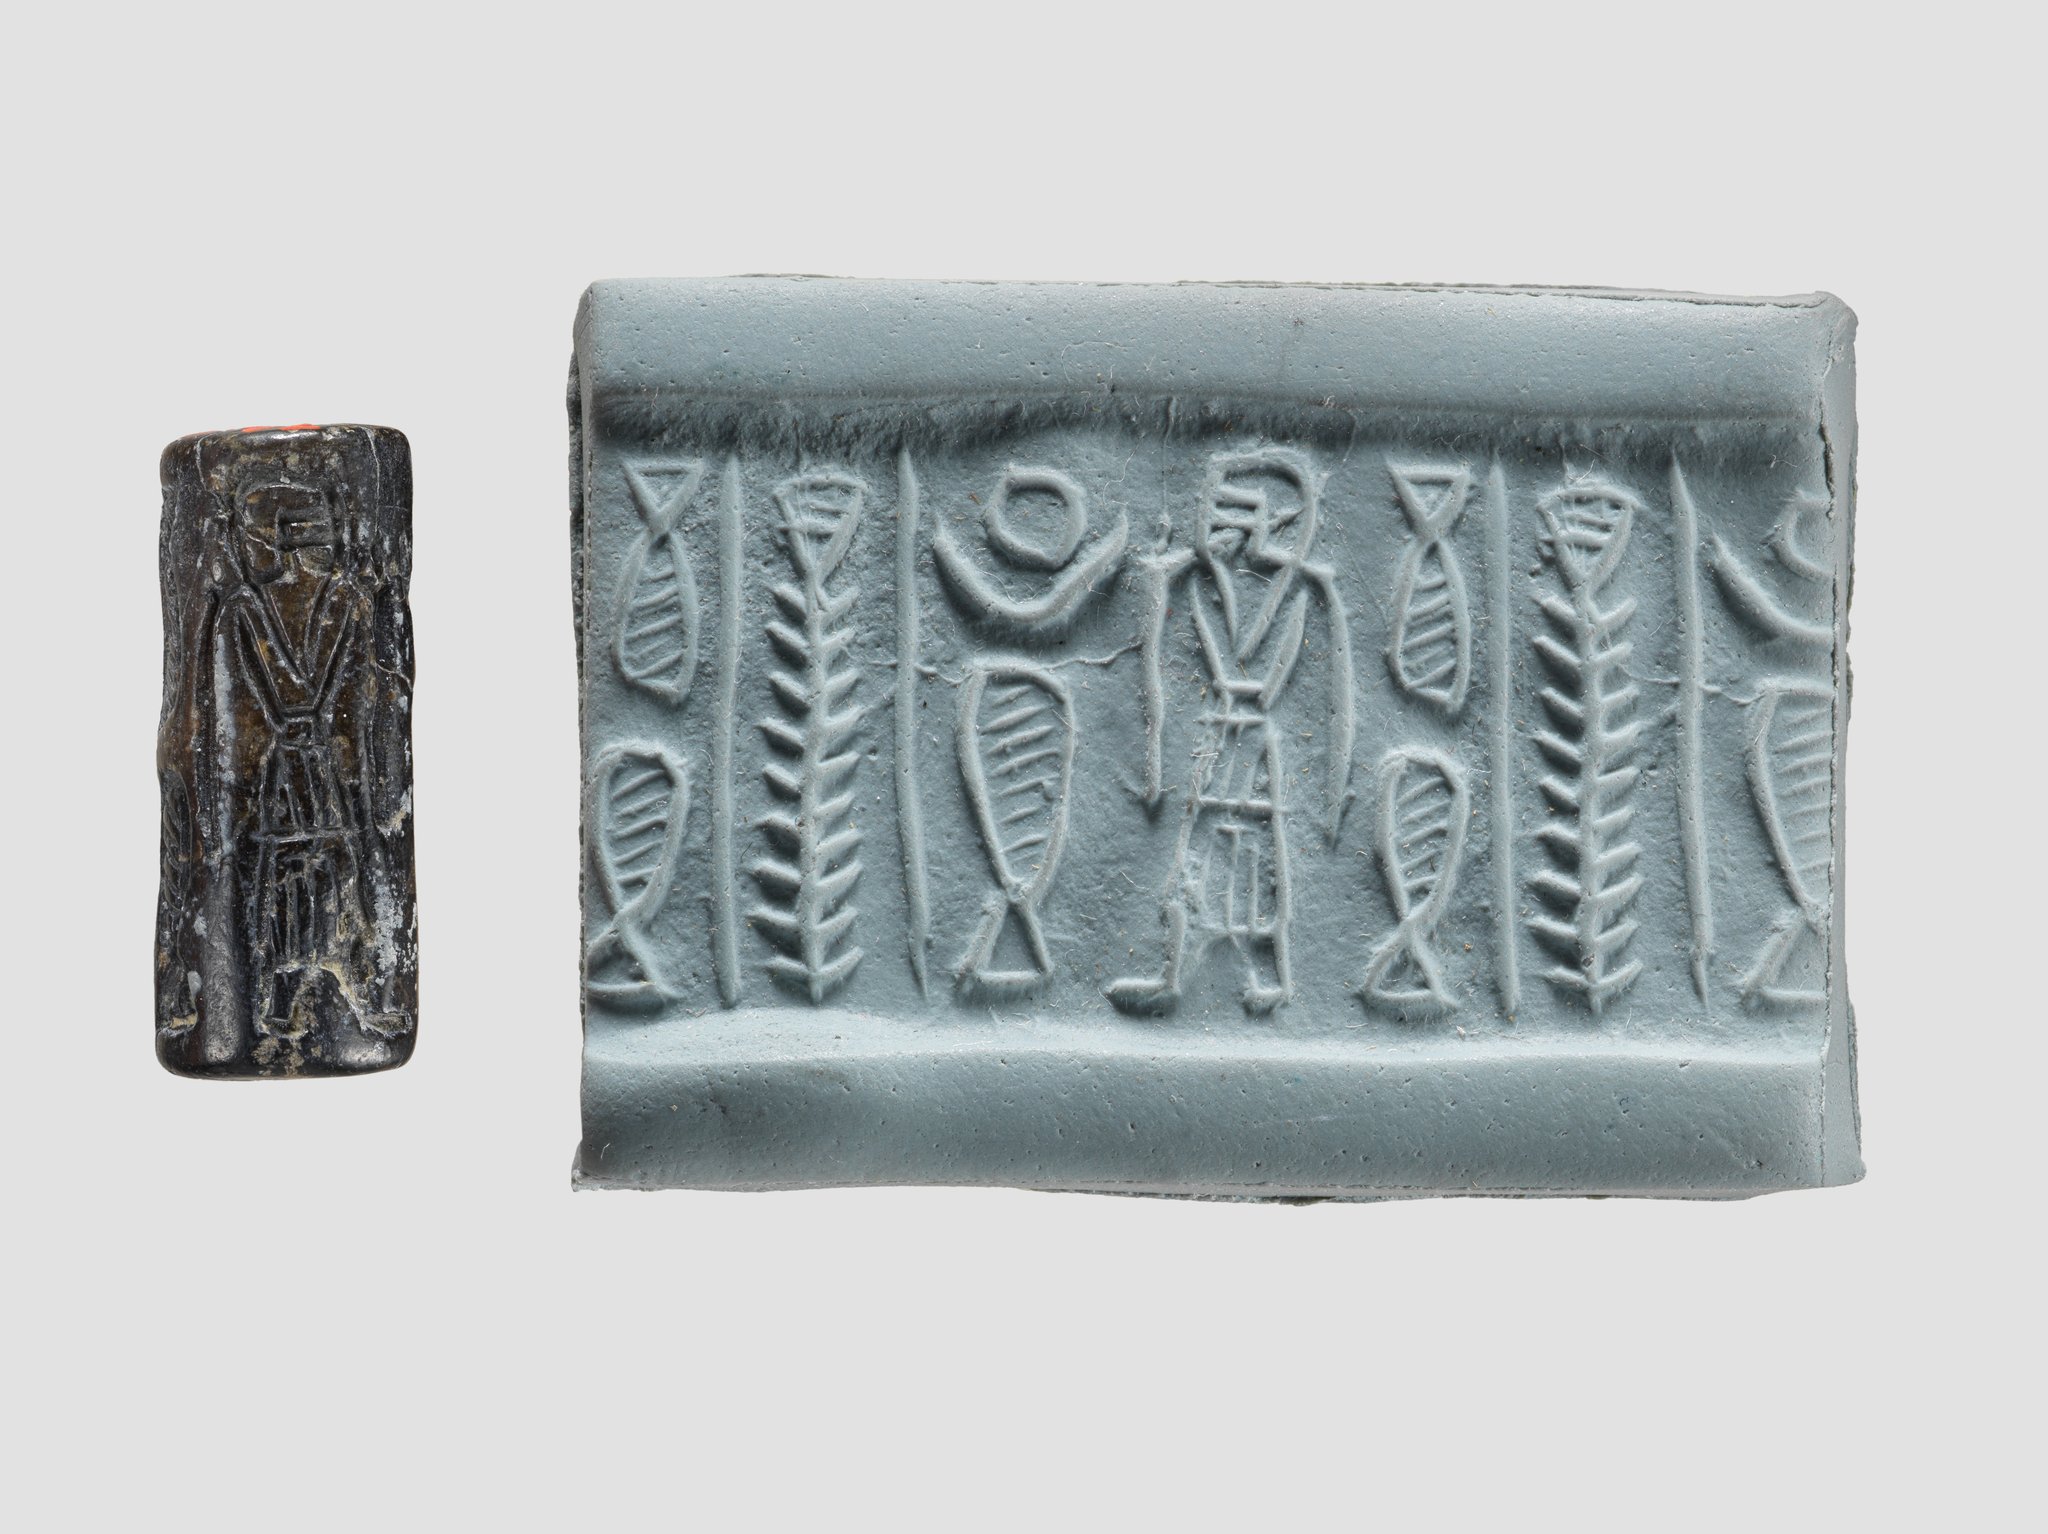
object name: cylinder seal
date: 1600-1101 BCE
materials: stone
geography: levant